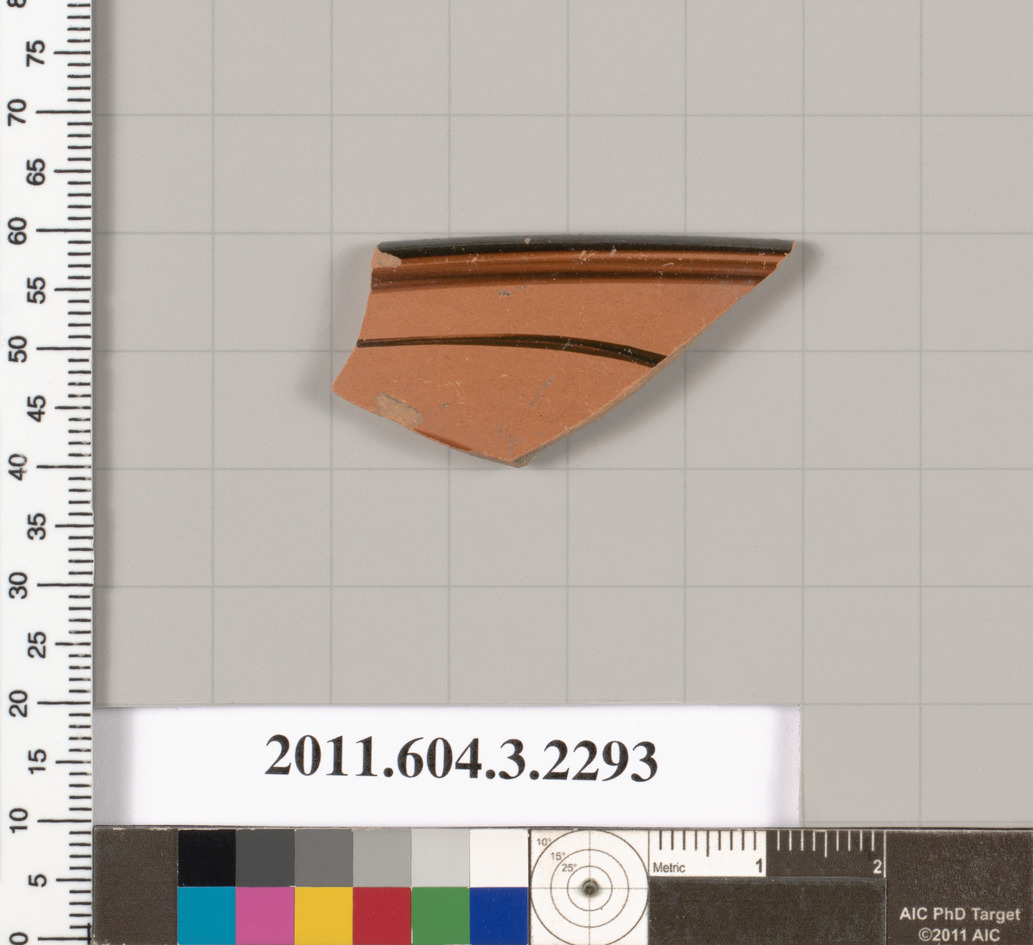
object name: kylix fragment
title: Terracotta rim fragment of a kylix: eye-cup (drinking cup)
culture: greek, attic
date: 540-500 BCE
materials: terracotta